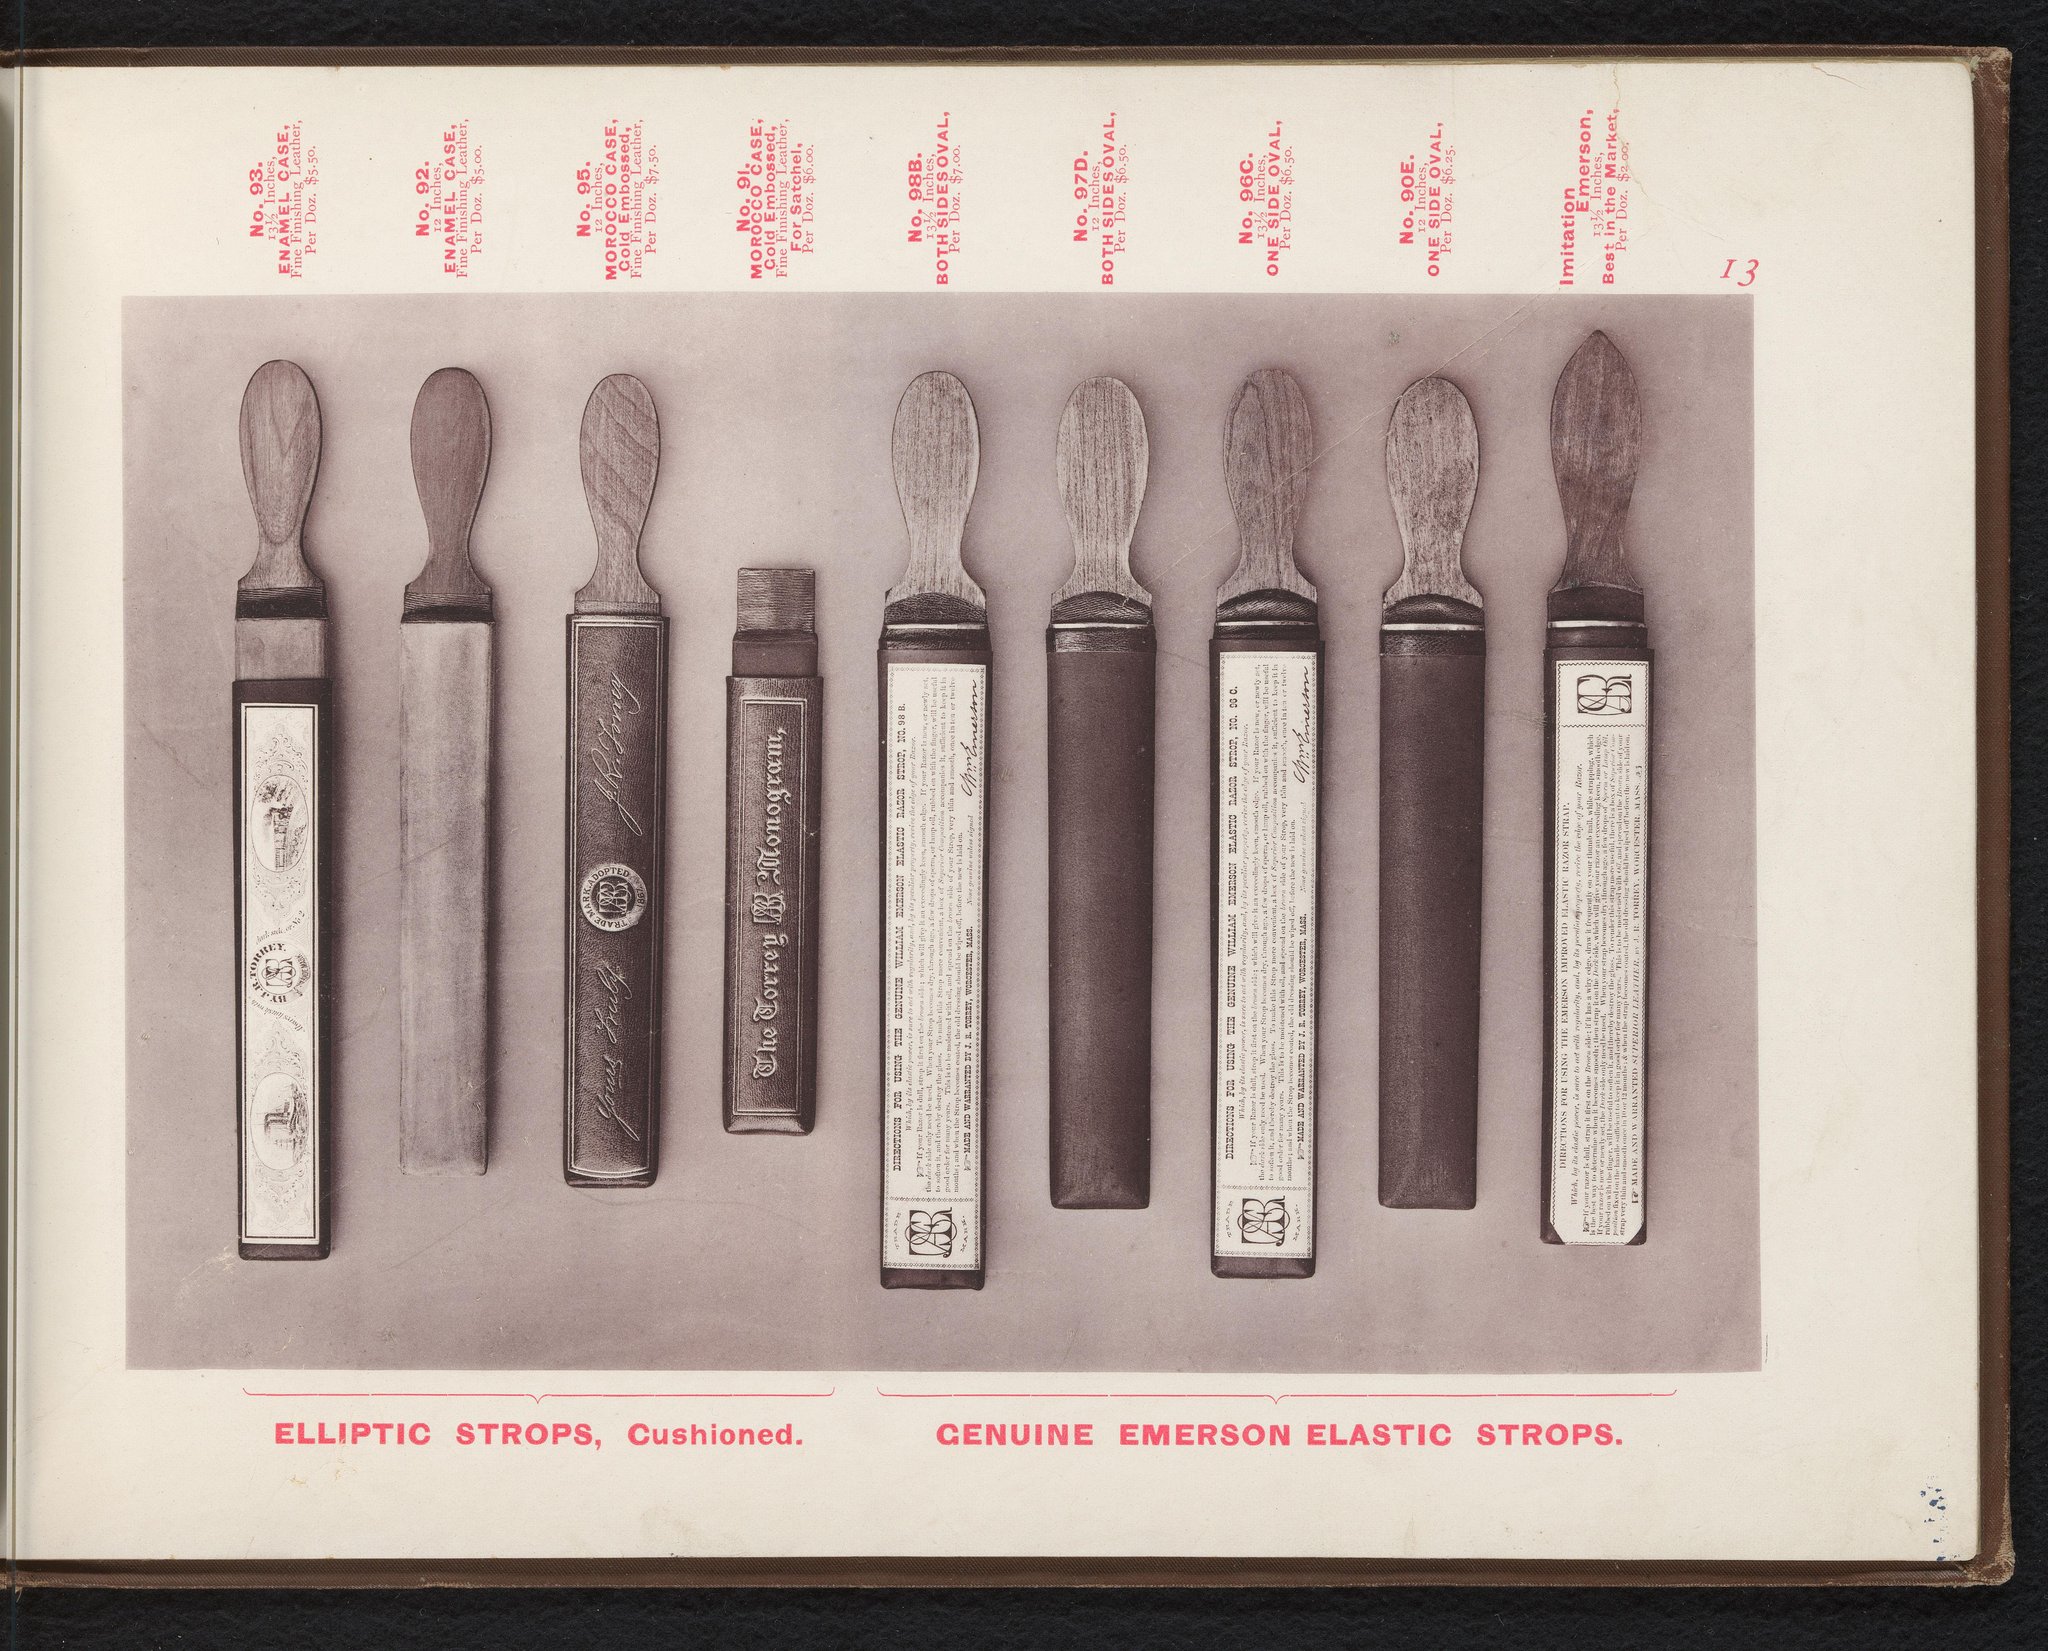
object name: photomechanical print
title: Elliptic strops, cushioned, genuine emerson elastic strops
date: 1876-1881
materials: paper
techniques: photograph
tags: care of the body, hygiene, razor